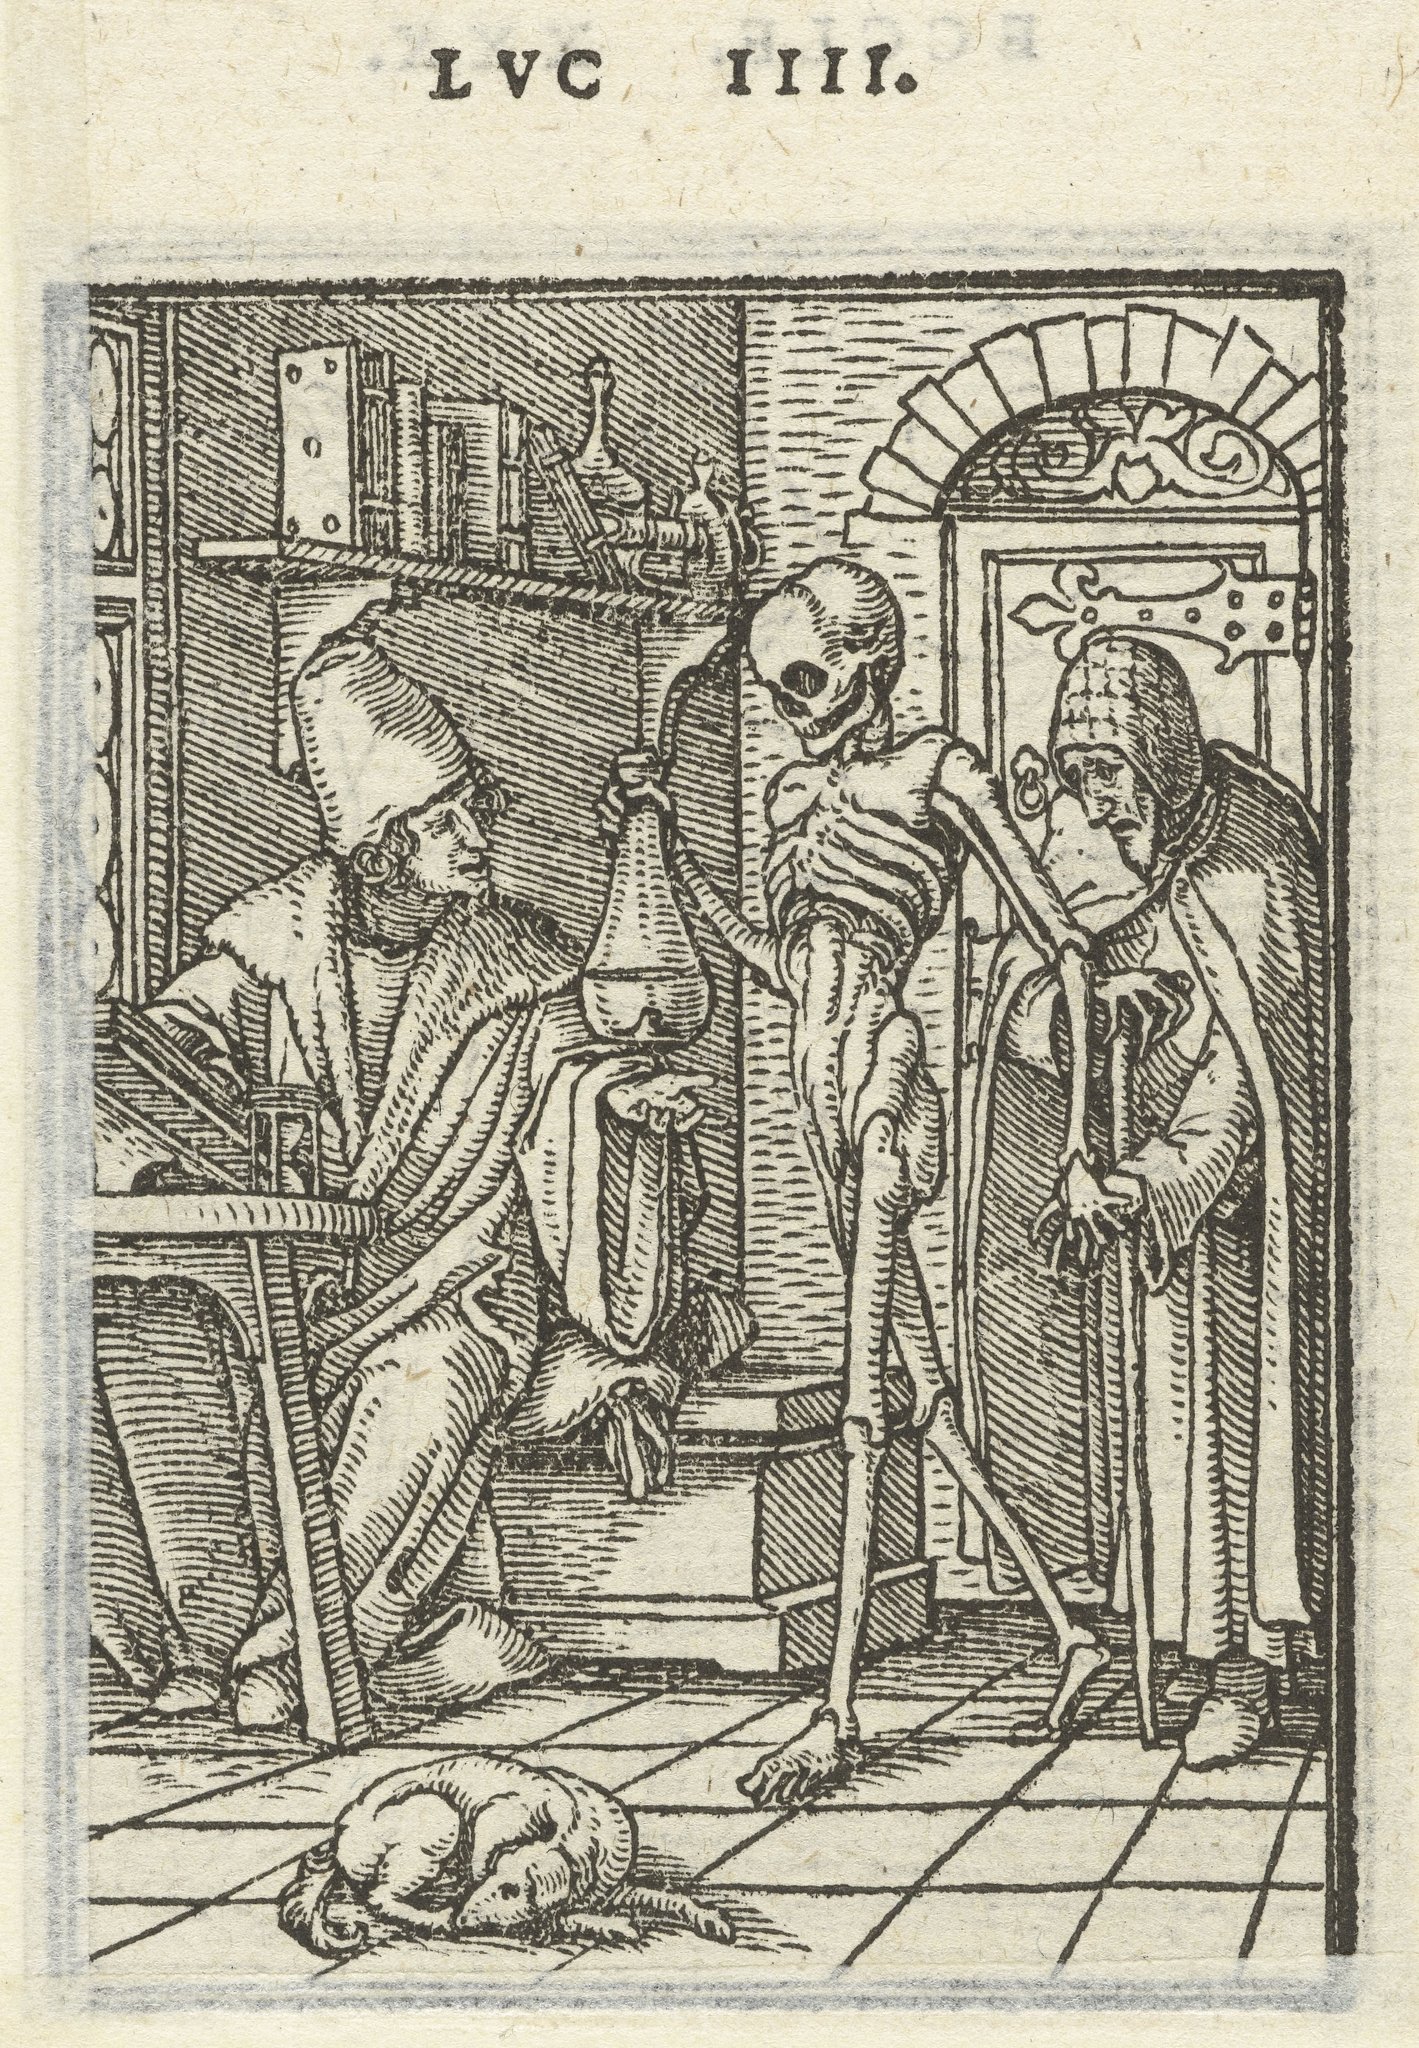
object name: book illustration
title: Arts en de Dood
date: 1524-1526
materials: paper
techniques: woodcut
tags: dance of death; death together with one or more human beings, physician, doctor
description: De houtblokken werden voor 1526 vervaardigd door Hans Lützelburg en pas in 1538 voor het eerst gebruikt als boekillustraties in: Les simulachres & historiees faces de la mort avtant elegamment pourtraictes que artificiellement imaginées... a Lyon, Soubsz l'escu de Coloigne, MDXXXVIII, (M. en G. Trechsel, voor F. Frellon in Lyon), 1538. Later verschenen nog andere uitgaven.